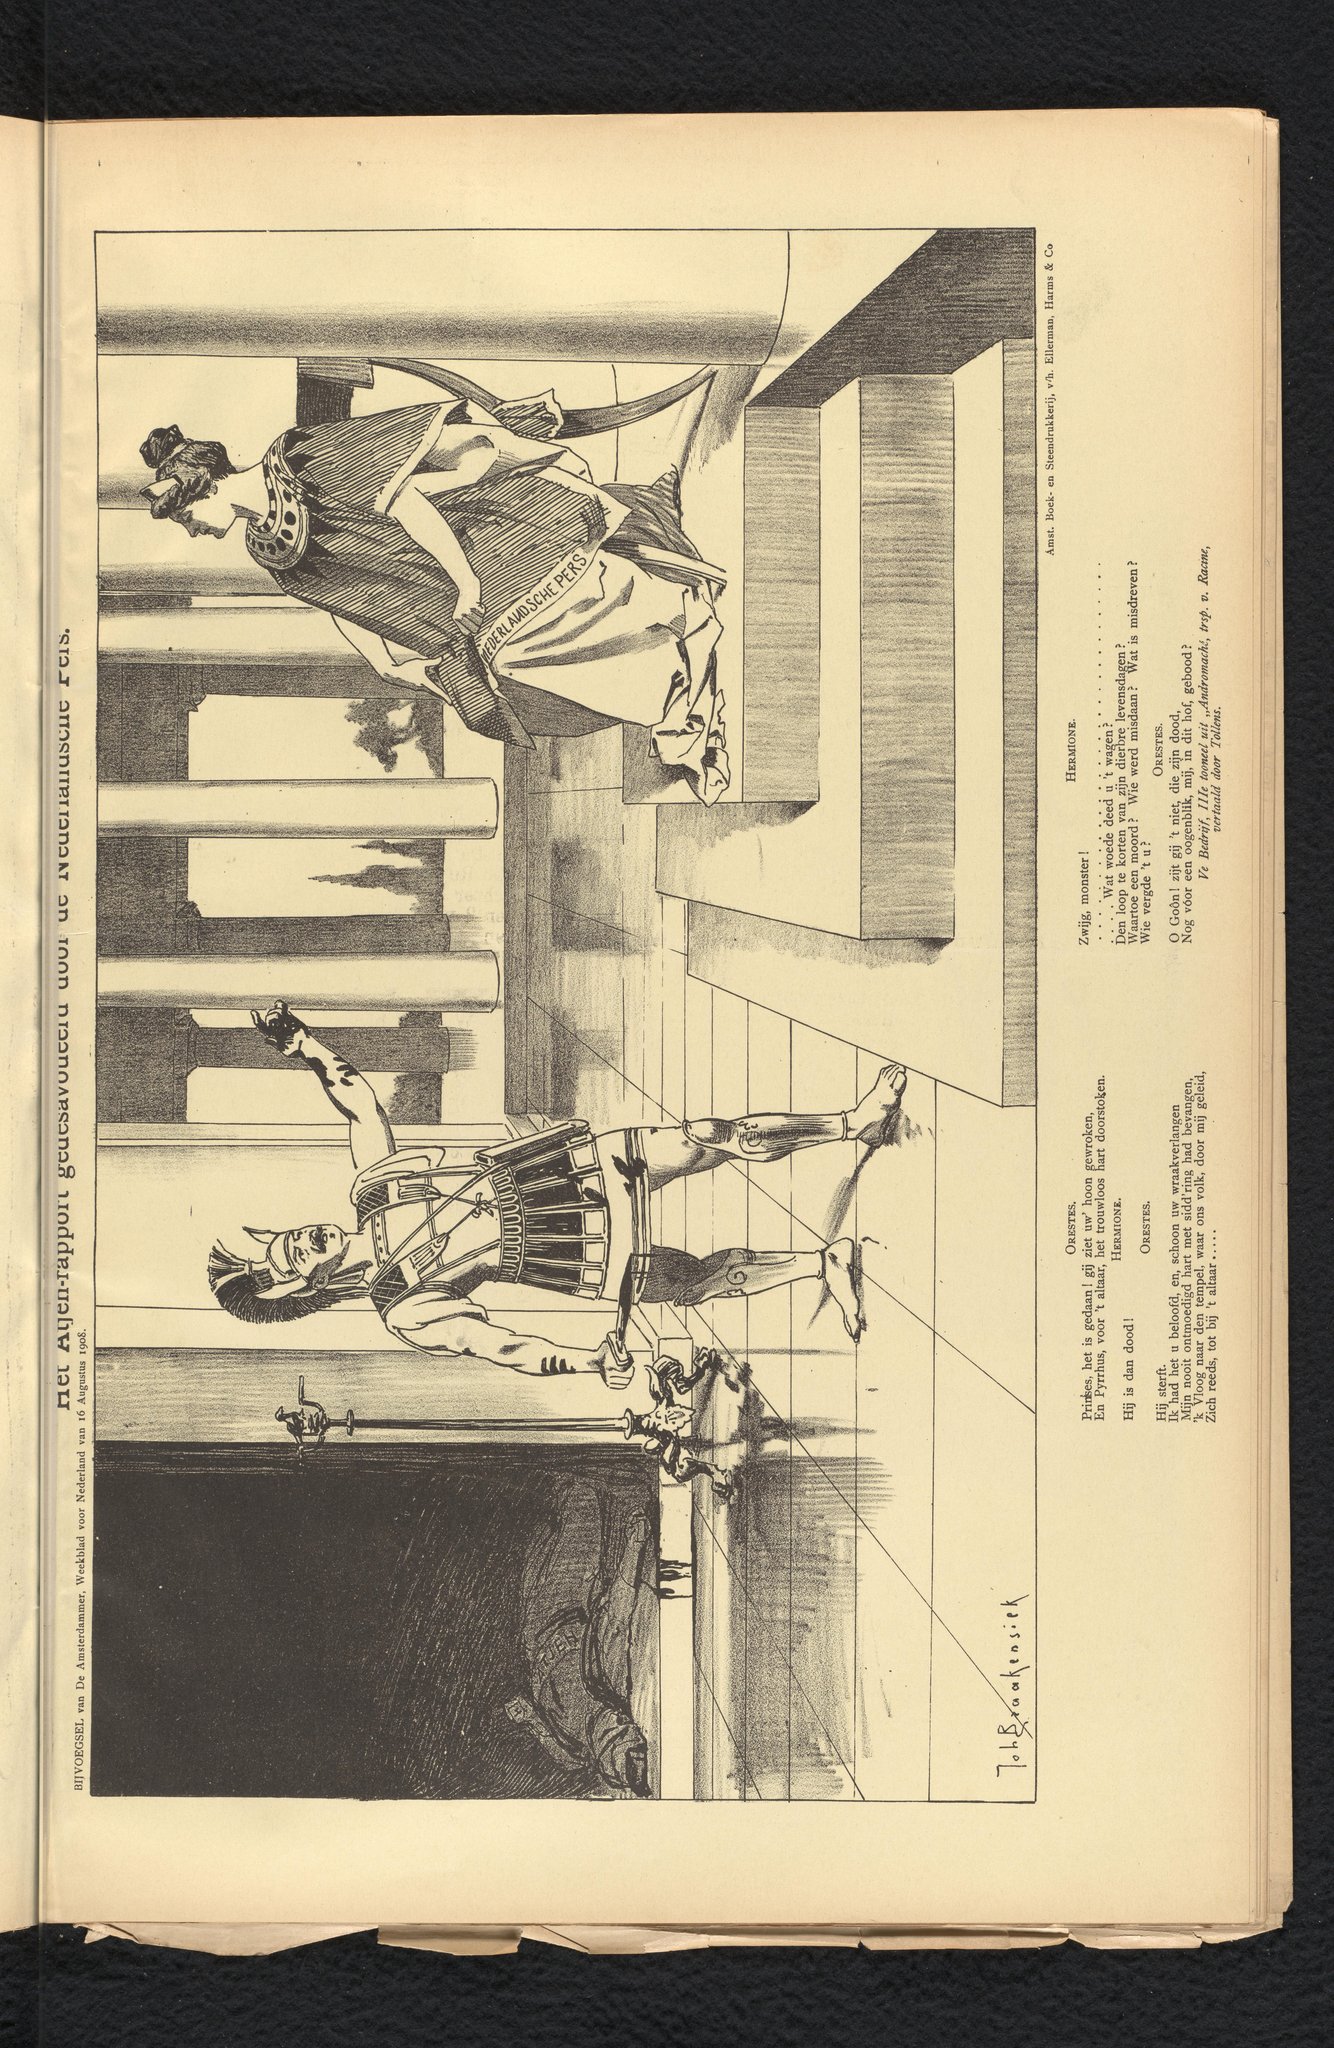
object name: cartoon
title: Het Atjeh-rapport gedesavoueerd door de Nederlandsche Pers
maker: johan braakensiek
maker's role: draughtsman, print maker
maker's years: 1858-1940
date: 1908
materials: paper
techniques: lithograph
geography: netherlands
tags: press, journalism, orestes and hermione, political caricatures and satires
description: Generaal Van Heutz of Minister van Koloniën Alexander Idenburg als Orestes met bloedig zwaard staande voor de Nederlandse Pers als Hermione op haar troon verklaart dat de moord is volbracht. Links het lichaam van het slachtoffer Atjeh.